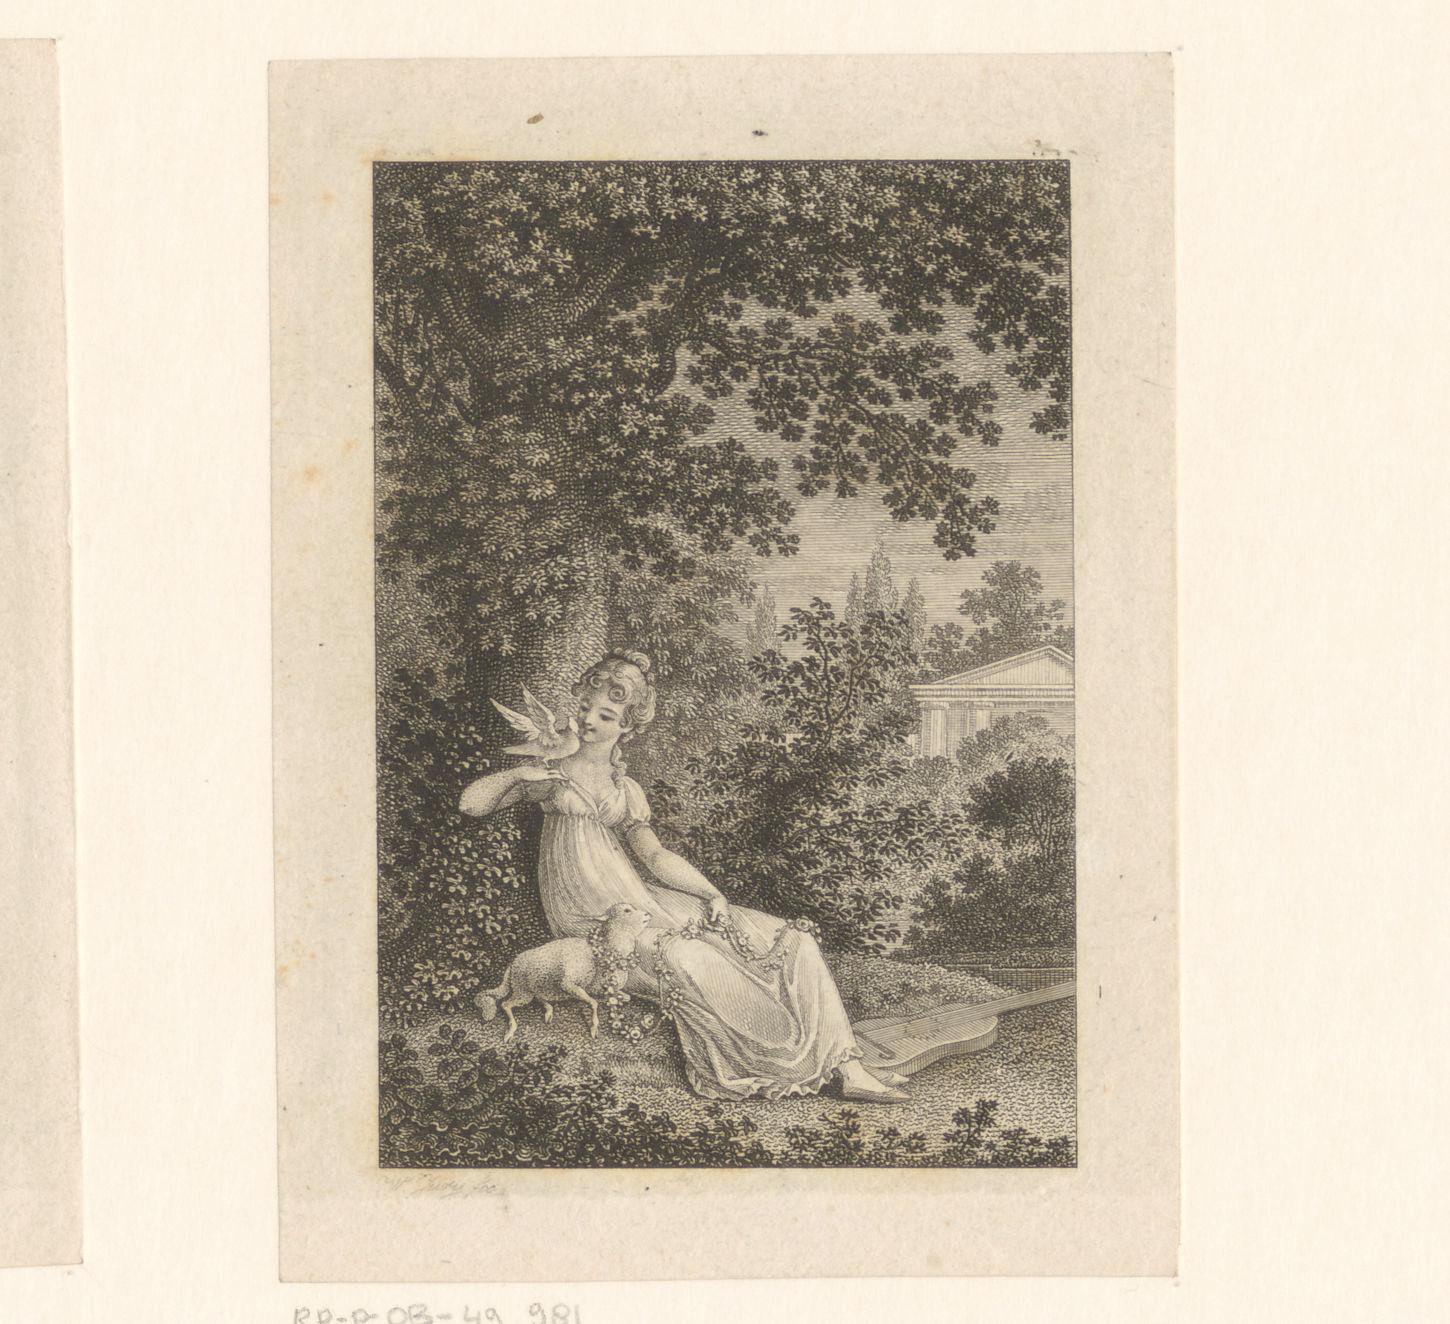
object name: print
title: Meisje met duif, lam, bloemenkrans en gitaar onder een boom gezeten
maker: wilhelm jury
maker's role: print maker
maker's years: 1763-1829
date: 1773-1829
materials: paper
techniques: engraving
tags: chastity, youth, adolescent (+ sitting)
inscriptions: collector's mark: Lugt 2228